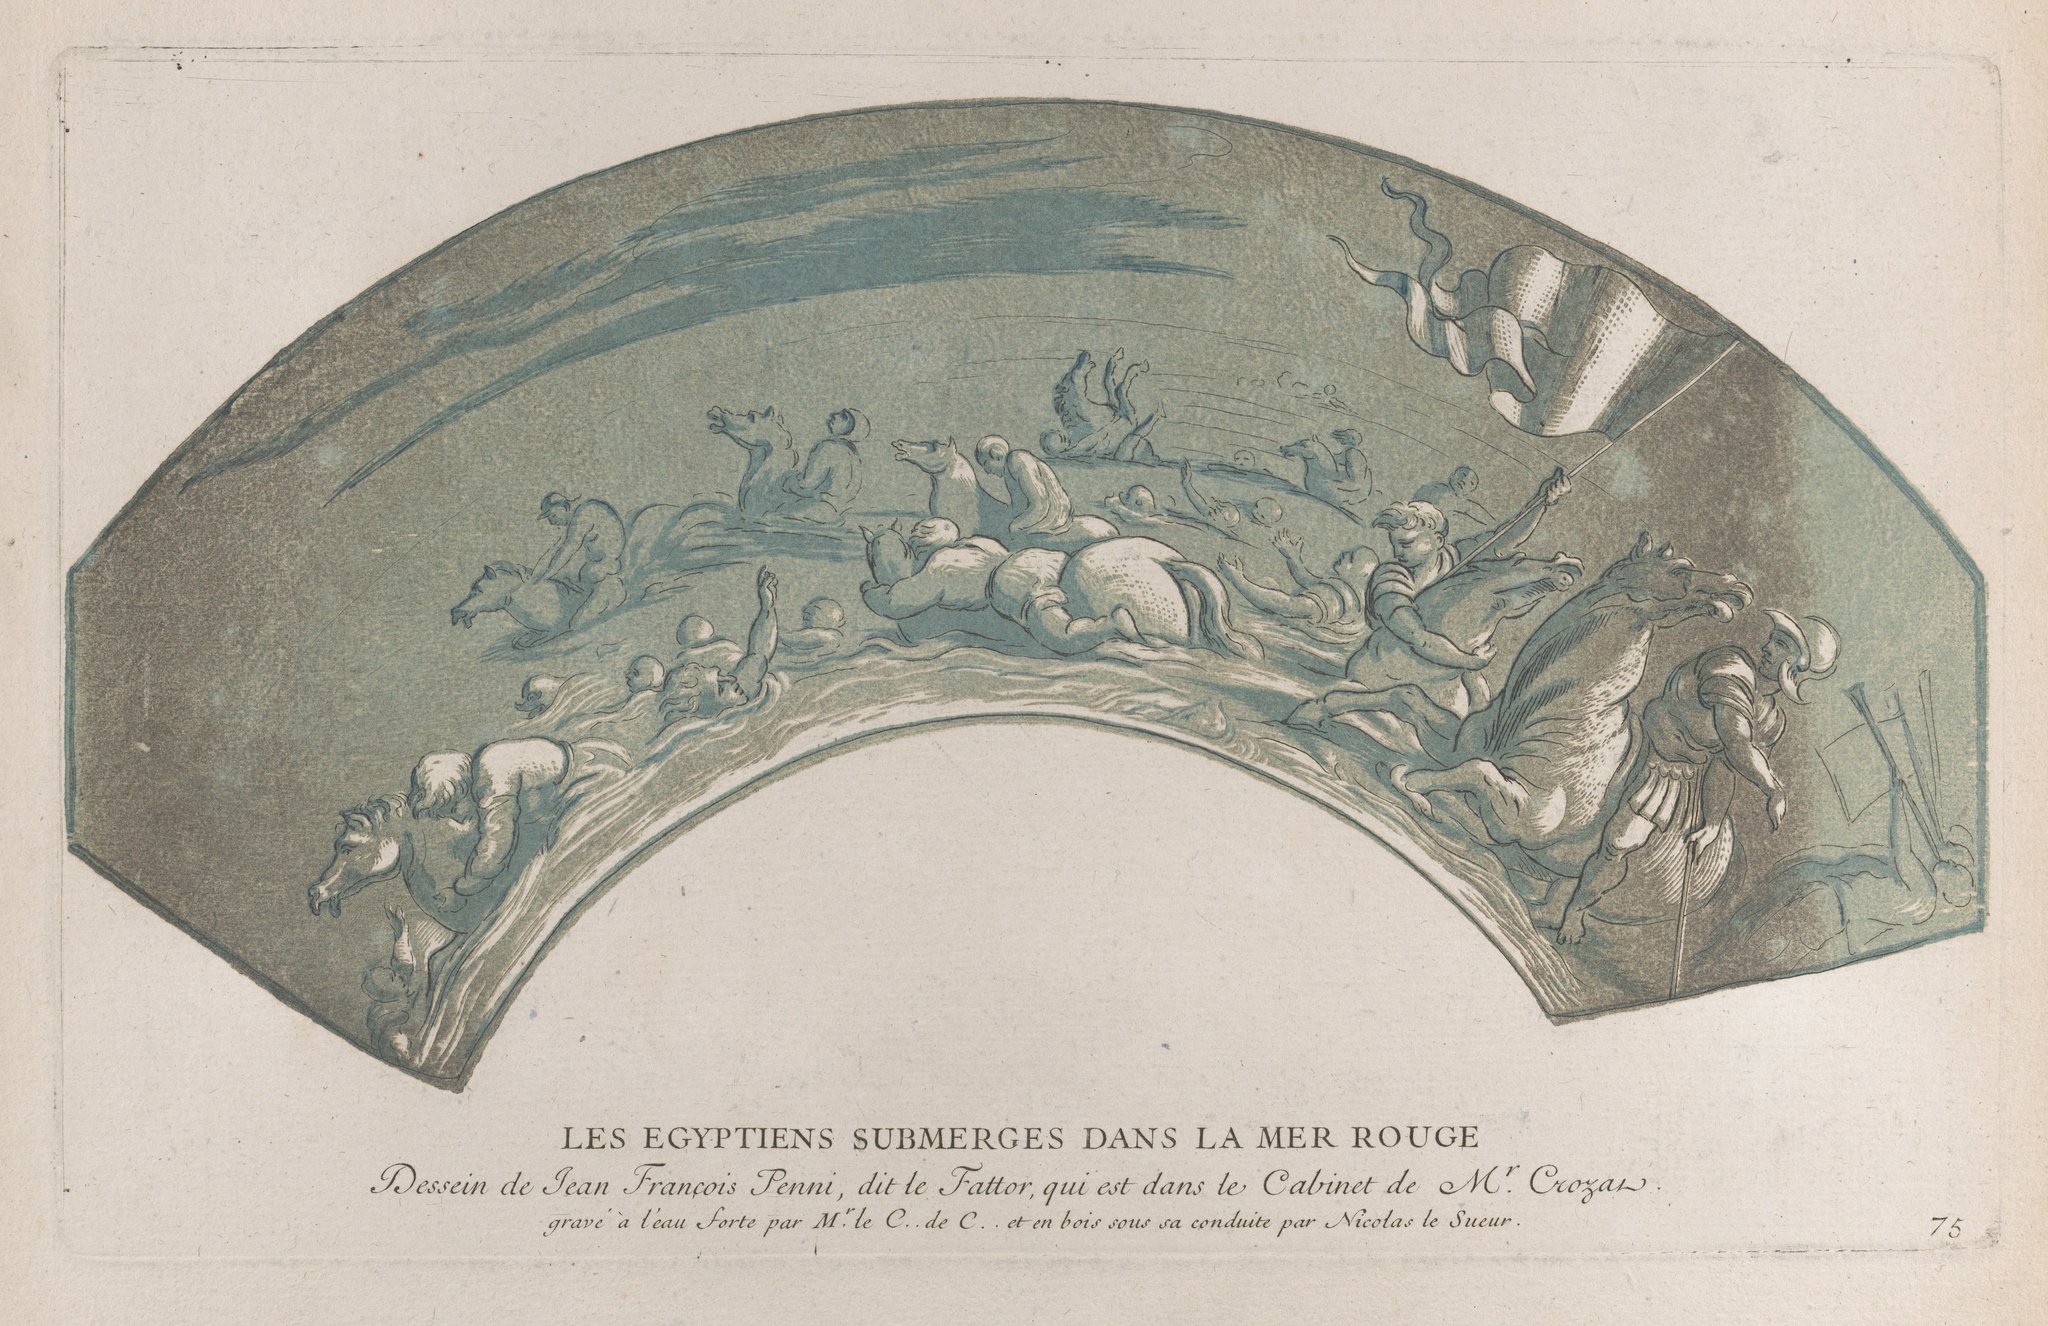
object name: print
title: Pharaoh's army engulfed by the Red Sea; from 'Recueil d'estampes d'après les plus beaux tableaux et d'après les plus beaux desseins qui sont en France, Cabinet Crozat' after Giovanni Francesco Penni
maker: anne claude philippe de tubières, comte de caylus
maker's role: artist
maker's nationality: french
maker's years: 1692-1765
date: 1729-1740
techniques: aquatint, woodcut, etching, printing